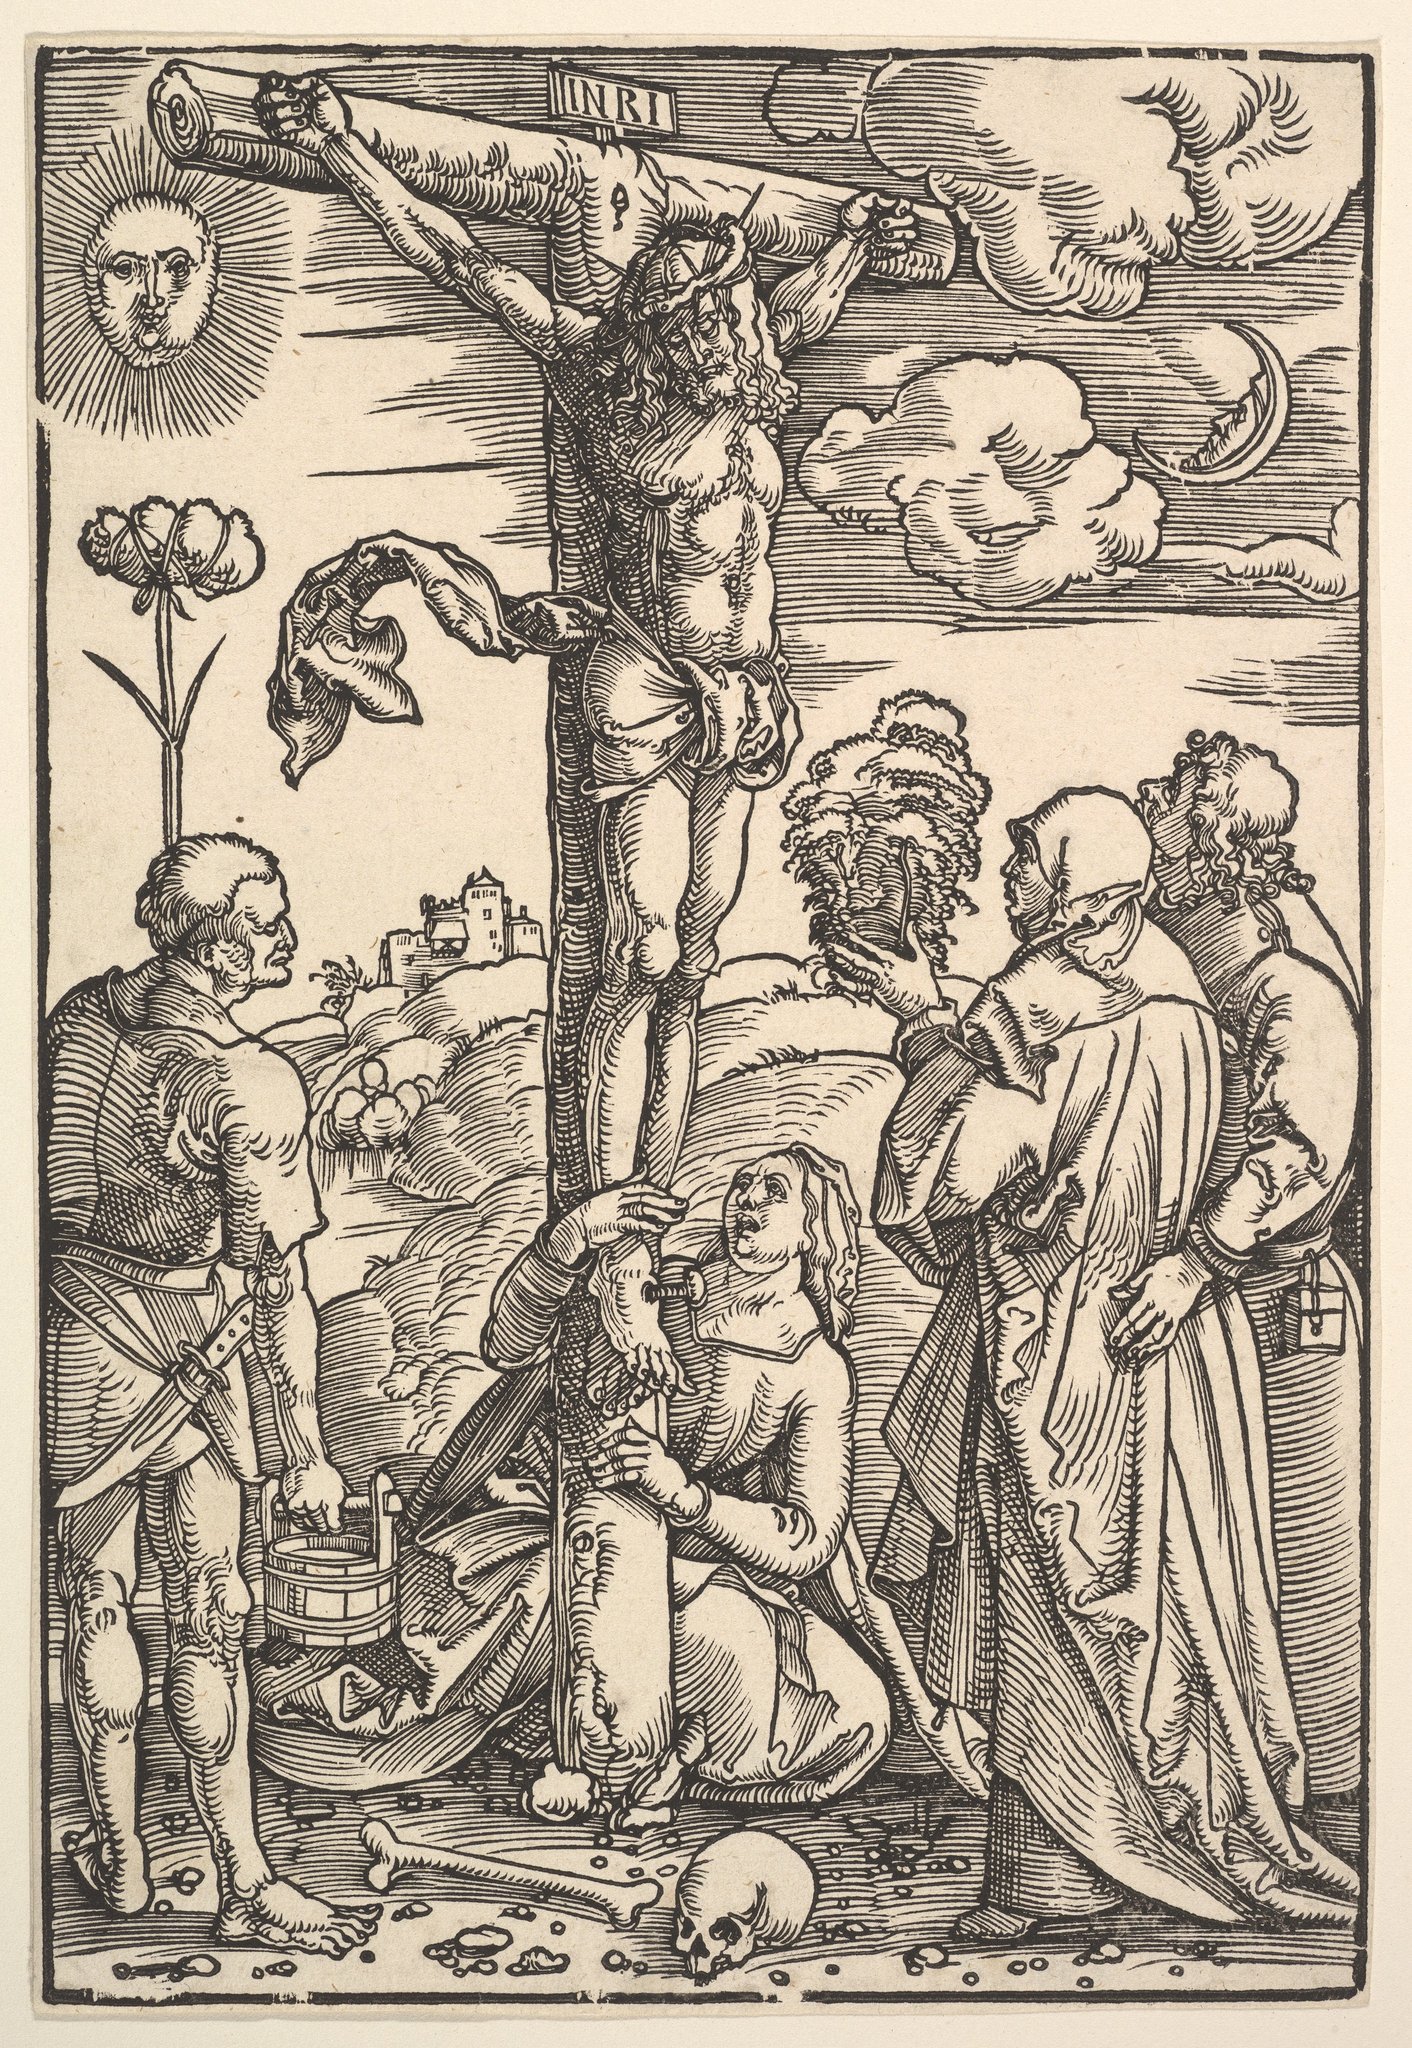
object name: print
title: Christ on the Cross with the Virgin and Saints Longinus, Mary Magdalen and John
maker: hans baldung (called hans baldung grien)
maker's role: artist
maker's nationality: german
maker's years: 1484-1545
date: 1505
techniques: woodcut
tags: christ,mary magdalene,virgin mary,crucifixion